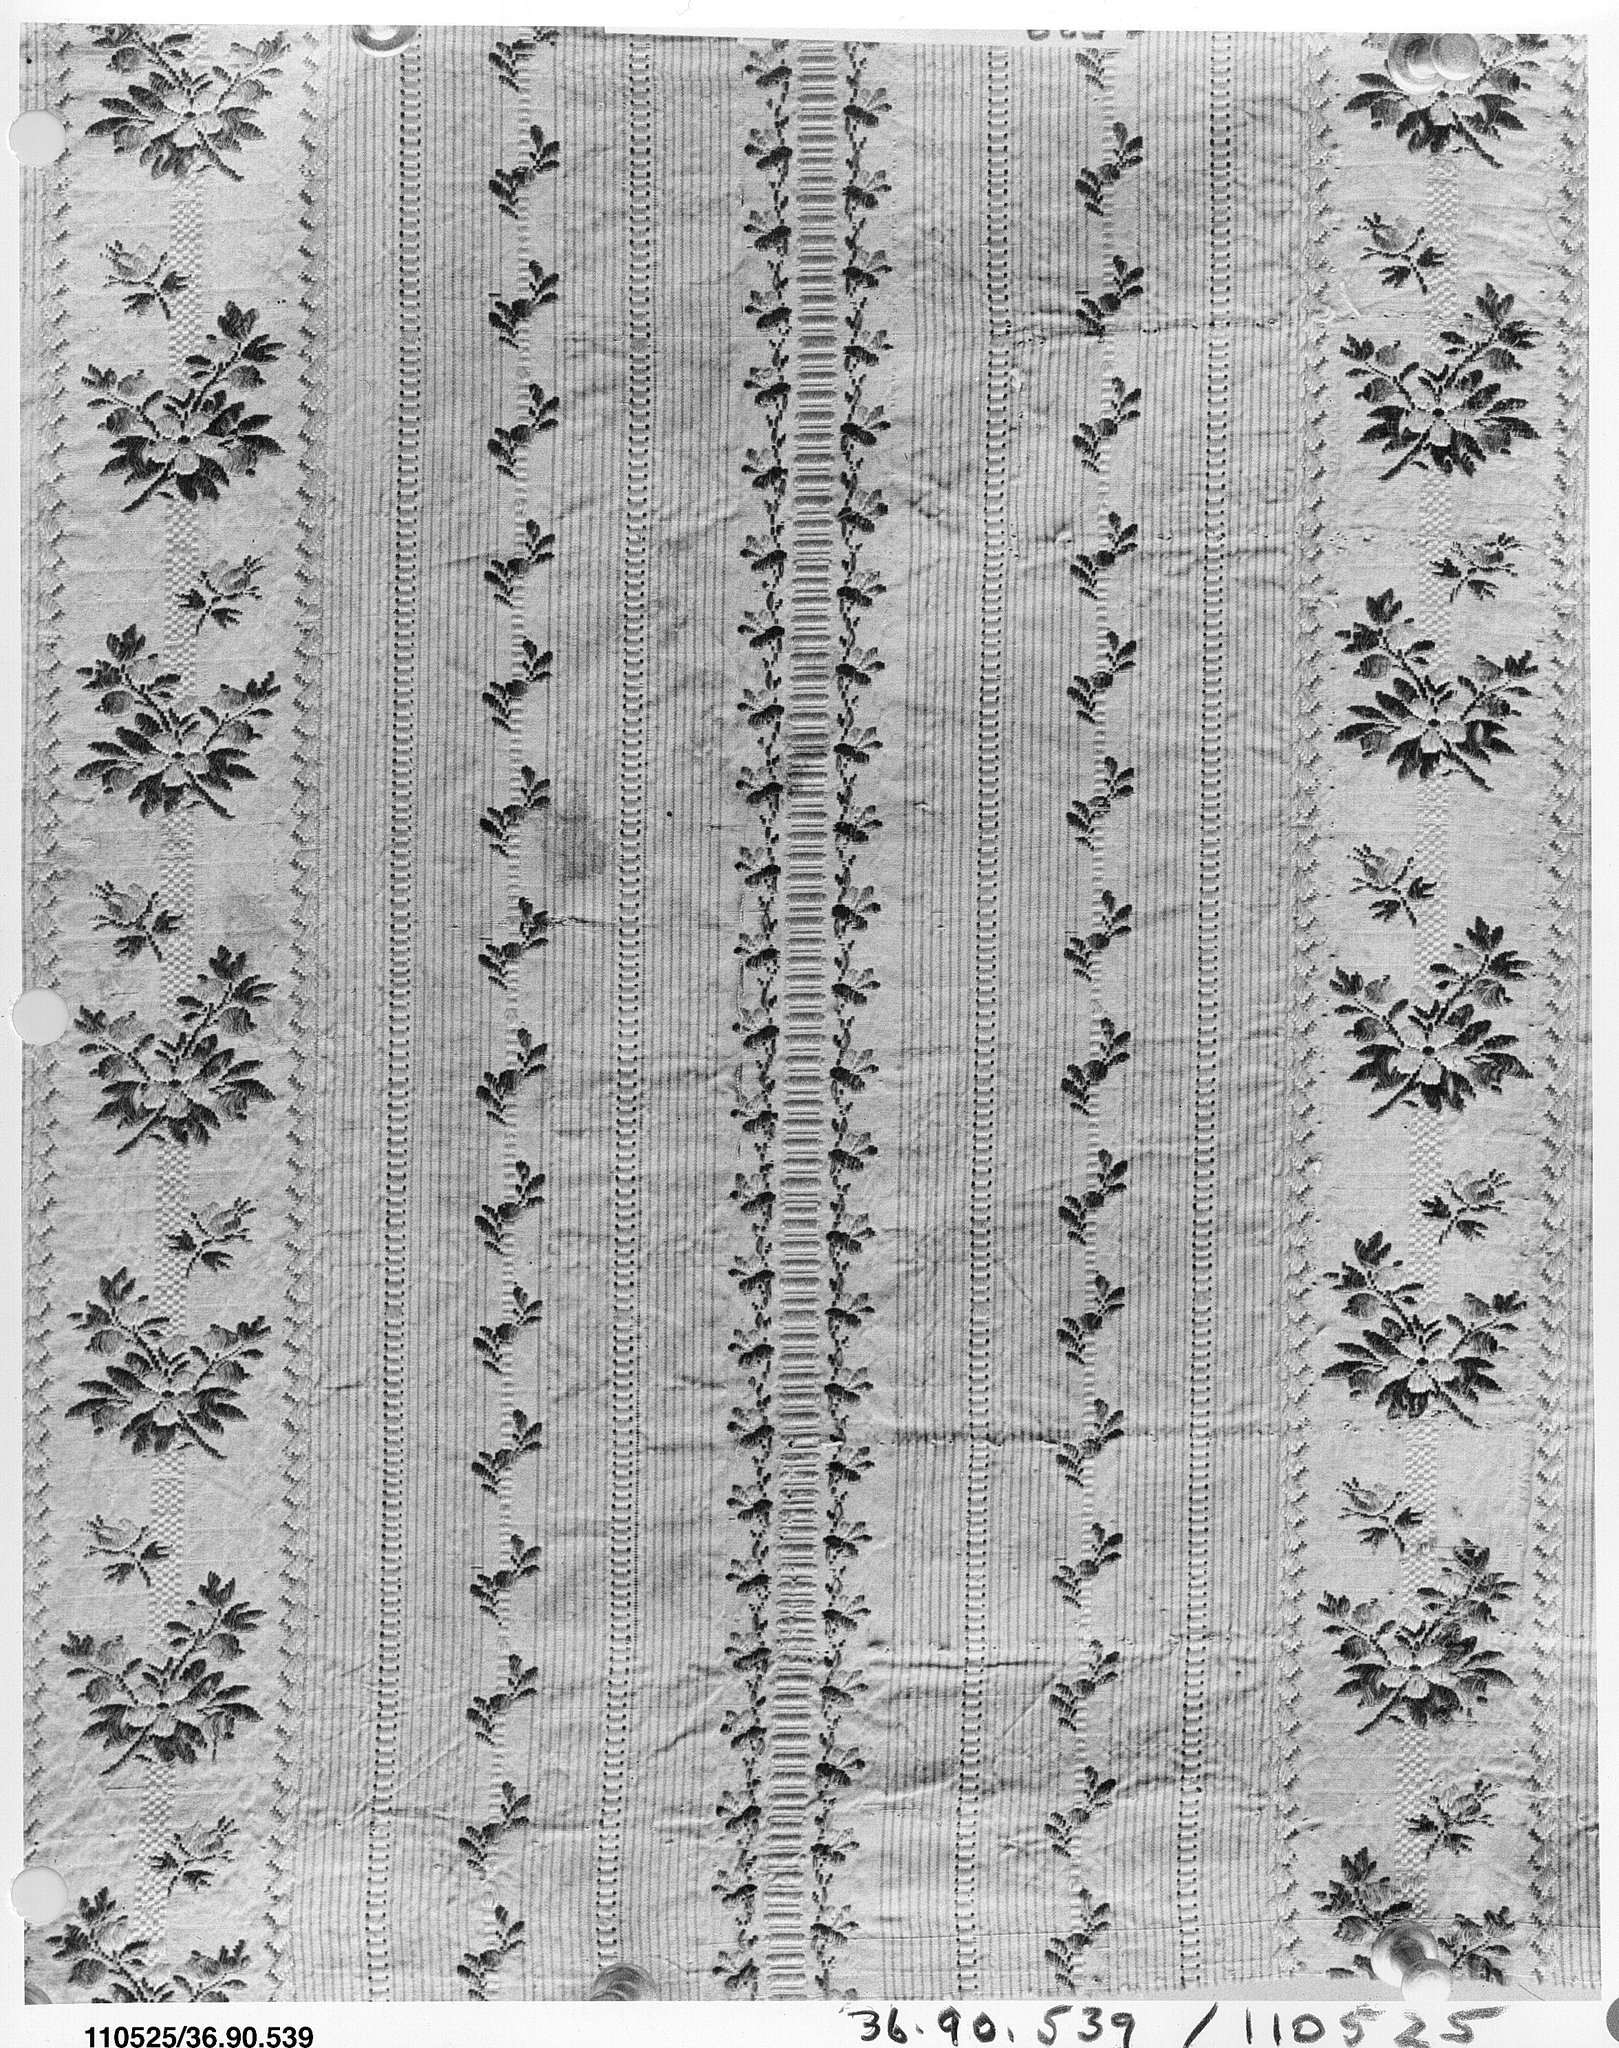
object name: piece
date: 1767-1800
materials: silk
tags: flowers